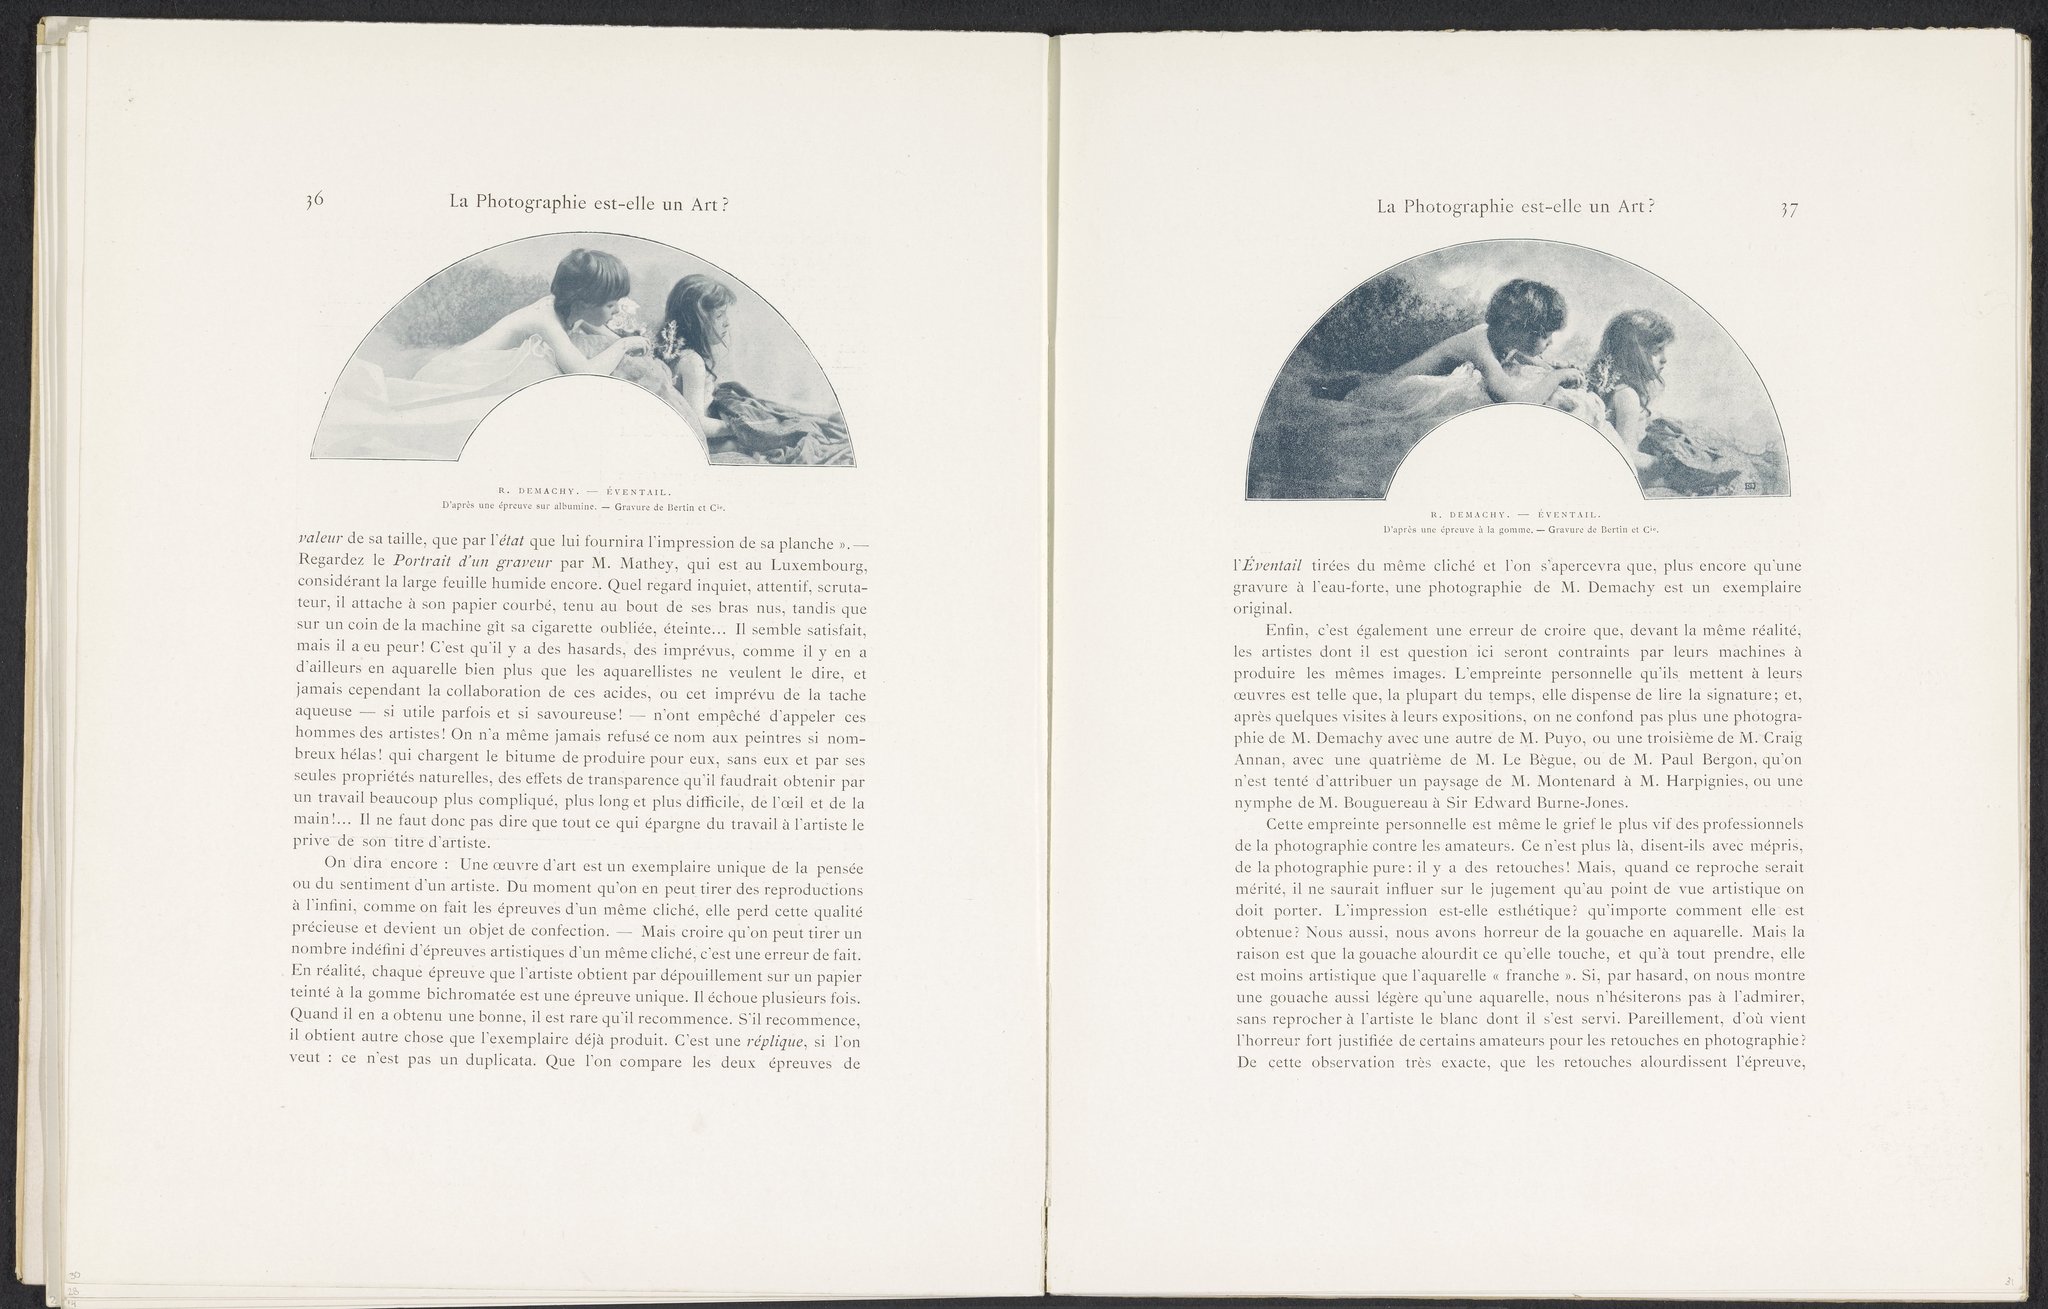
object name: page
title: Jongen en meisje met ontbloot bovenlijf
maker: robert demachy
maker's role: fotograaf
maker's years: 1859-1936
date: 1889-1899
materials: paper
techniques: autotype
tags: boy (child between toddler and youth), girl (child between toddler and youth)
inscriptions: name